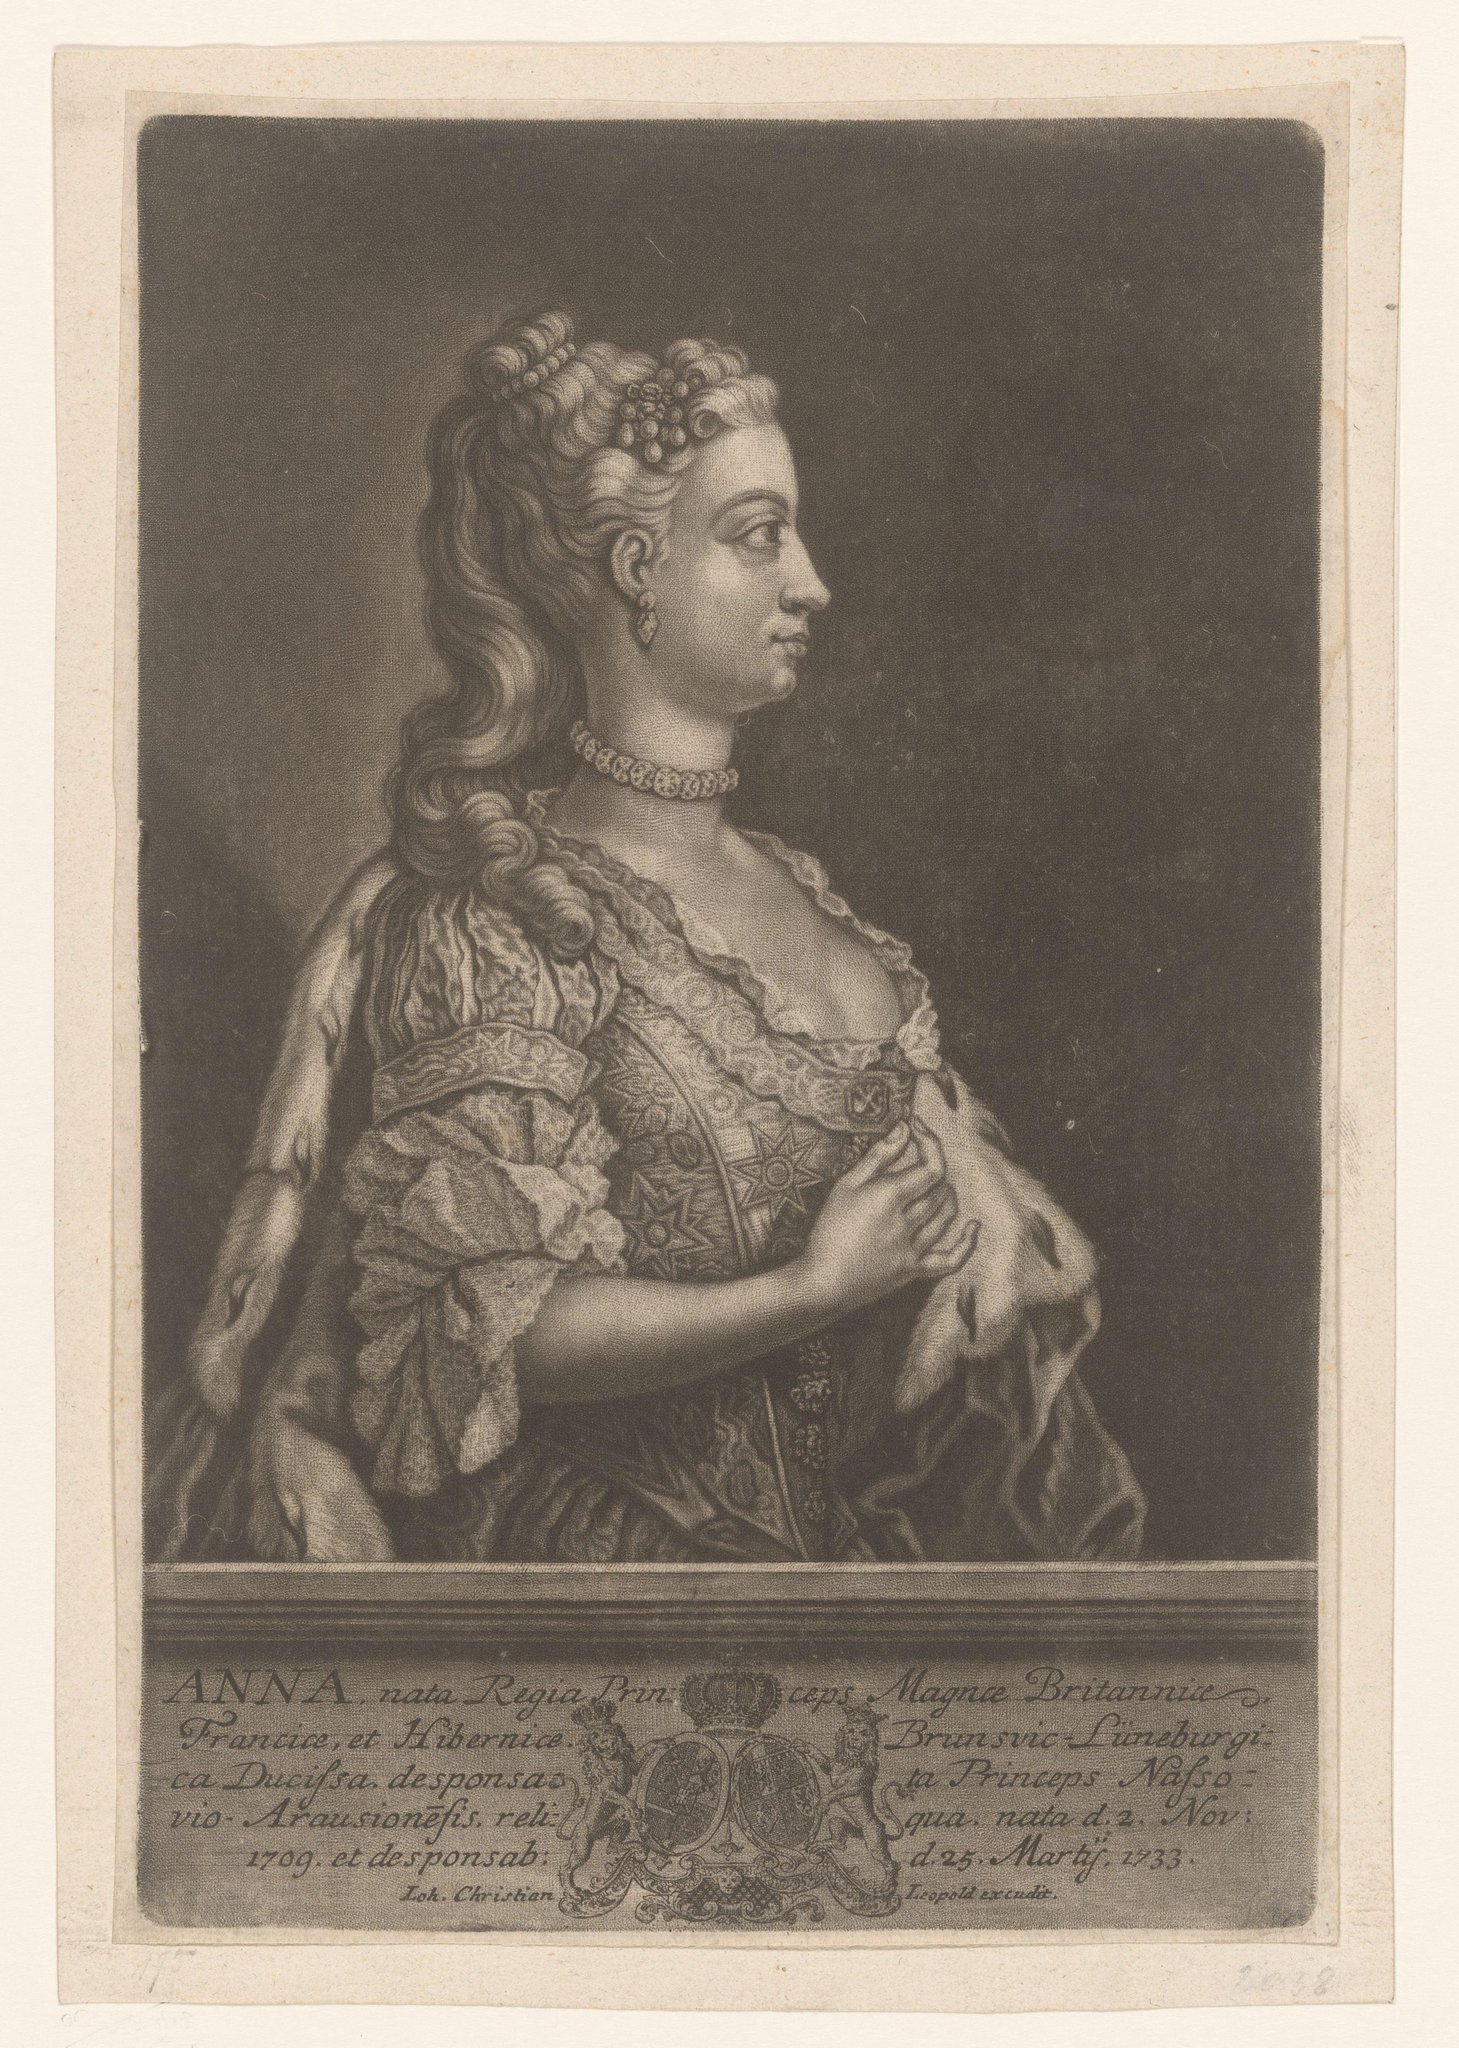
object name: print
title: Portret van Anna Stuart, koningin van Engeland en Schotland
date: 1733-1755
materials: paper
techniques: mezzotint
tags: london, anna stuart (koningin van engeland en schotland), historical persons - bb - woman, armorial bearing, heraldry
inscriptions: collector's mark: Lugt 2228